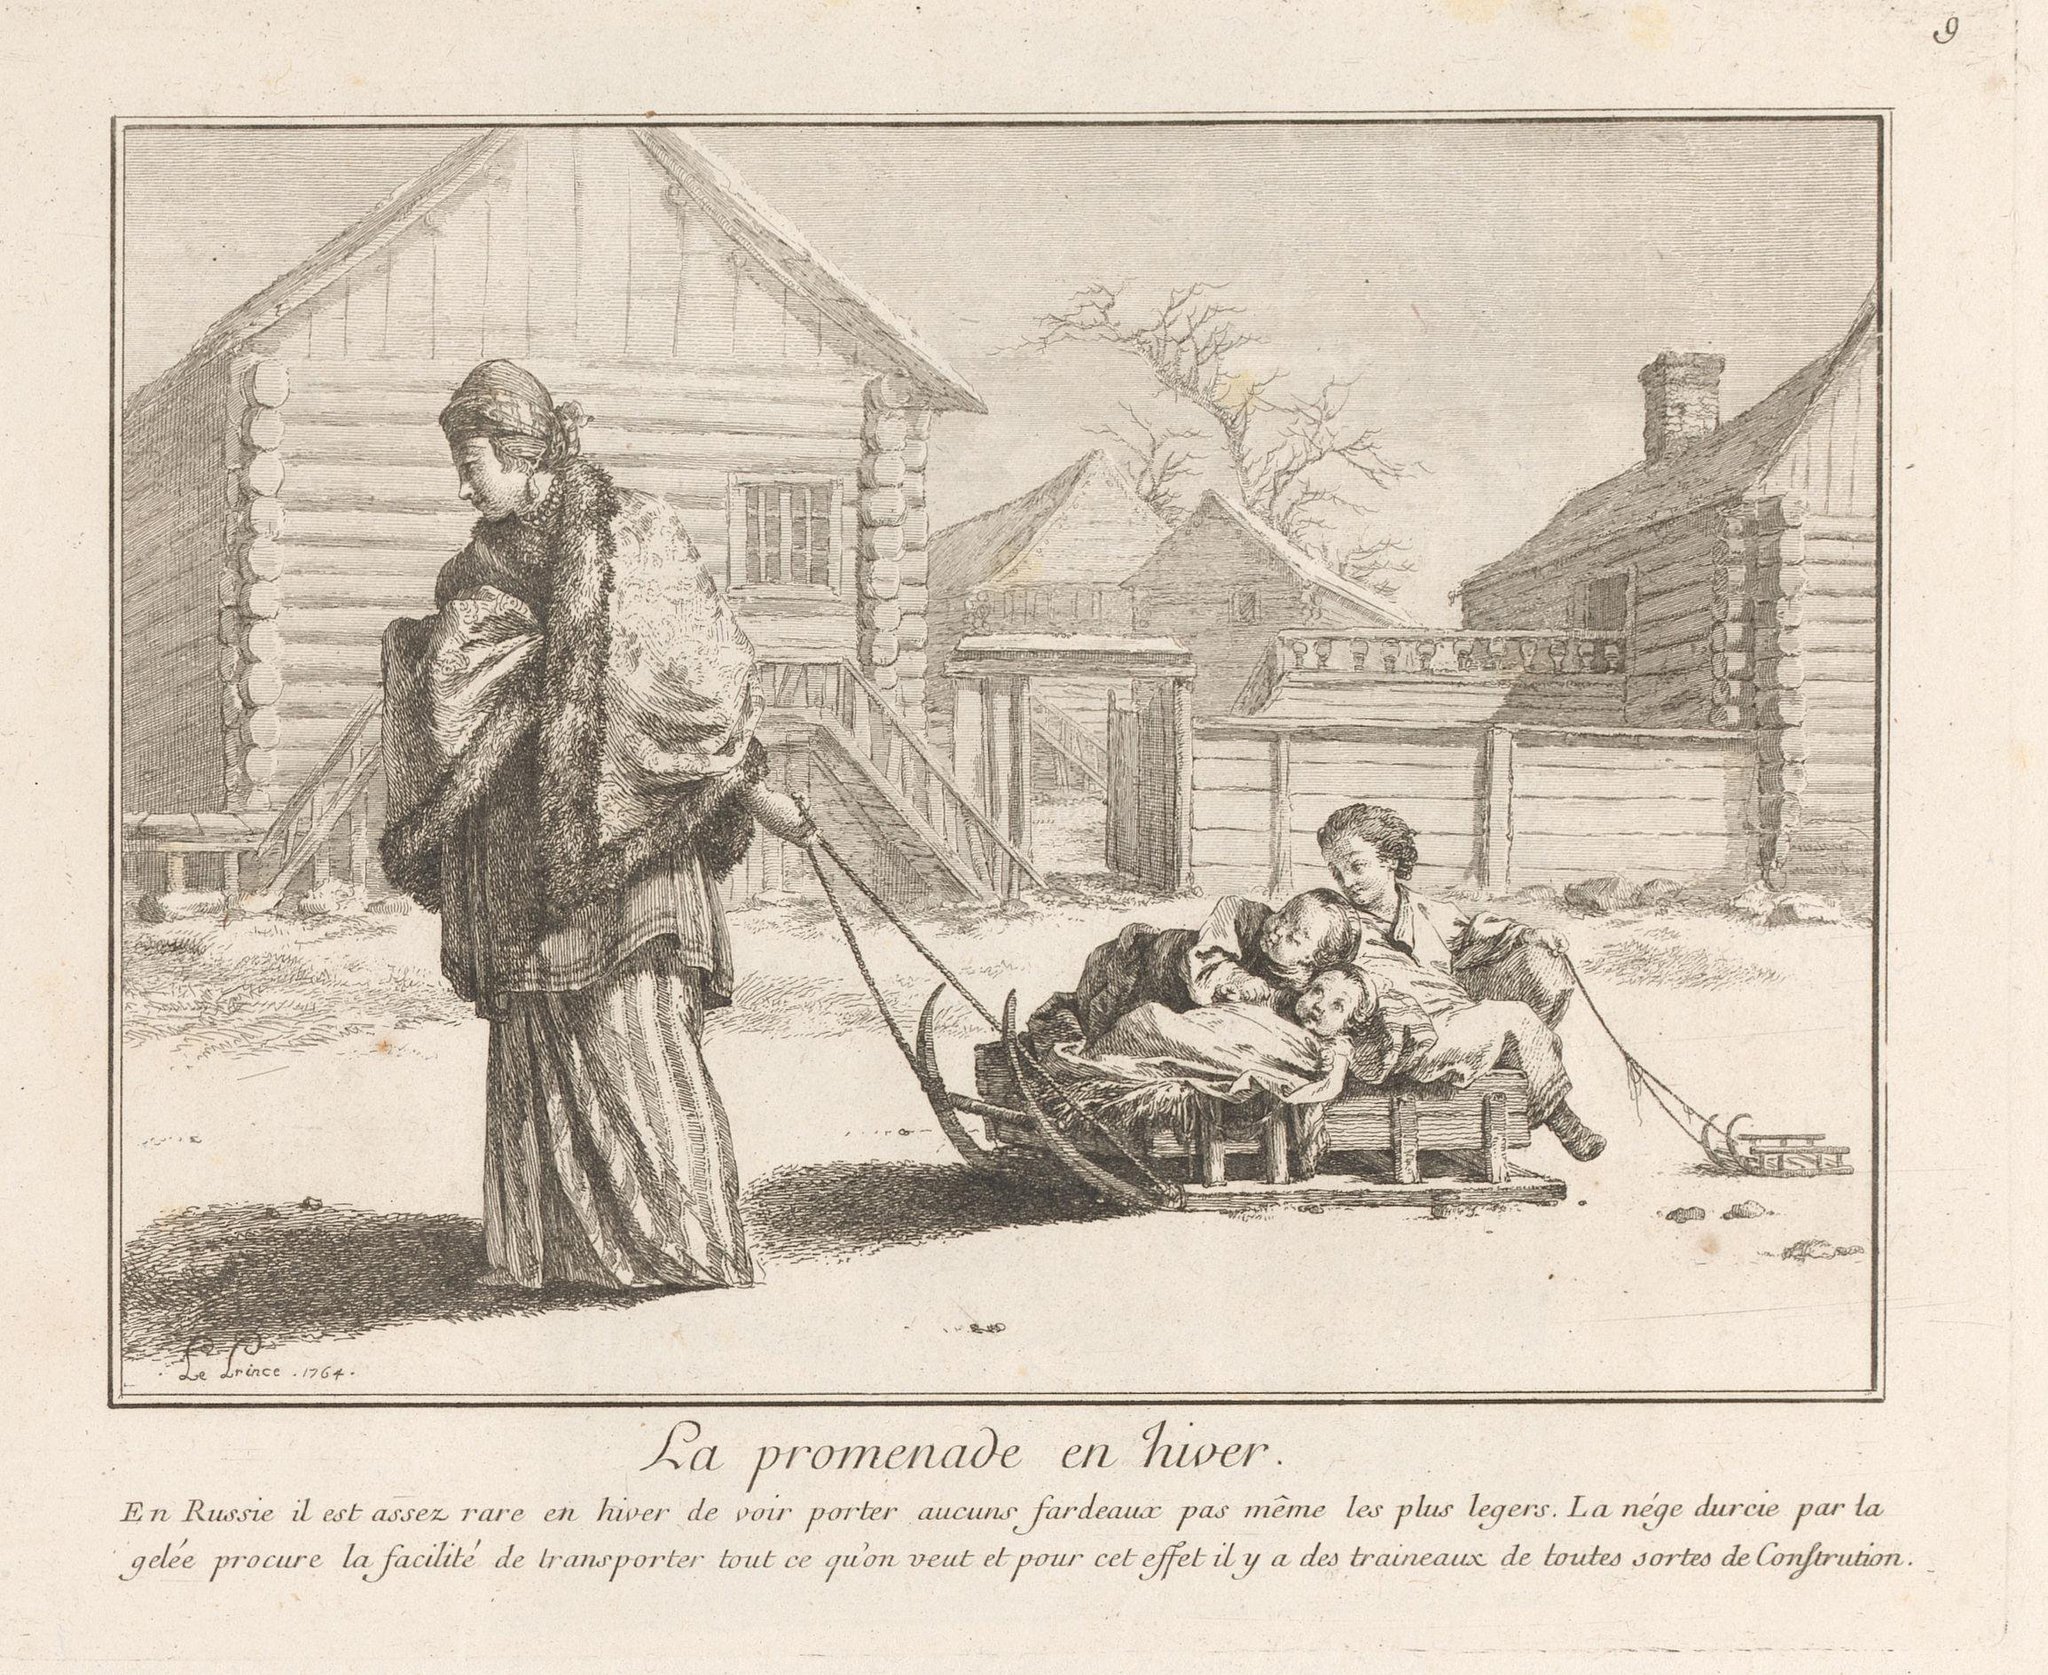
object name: album leaf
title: Divers Ajustements et Usages de Russie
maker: jean baptist leprince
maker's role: draughtsman, print maker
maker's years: 1734-1781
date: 1764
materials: paper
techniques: etching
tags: sledge, sleigh (winter sports)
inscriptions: date